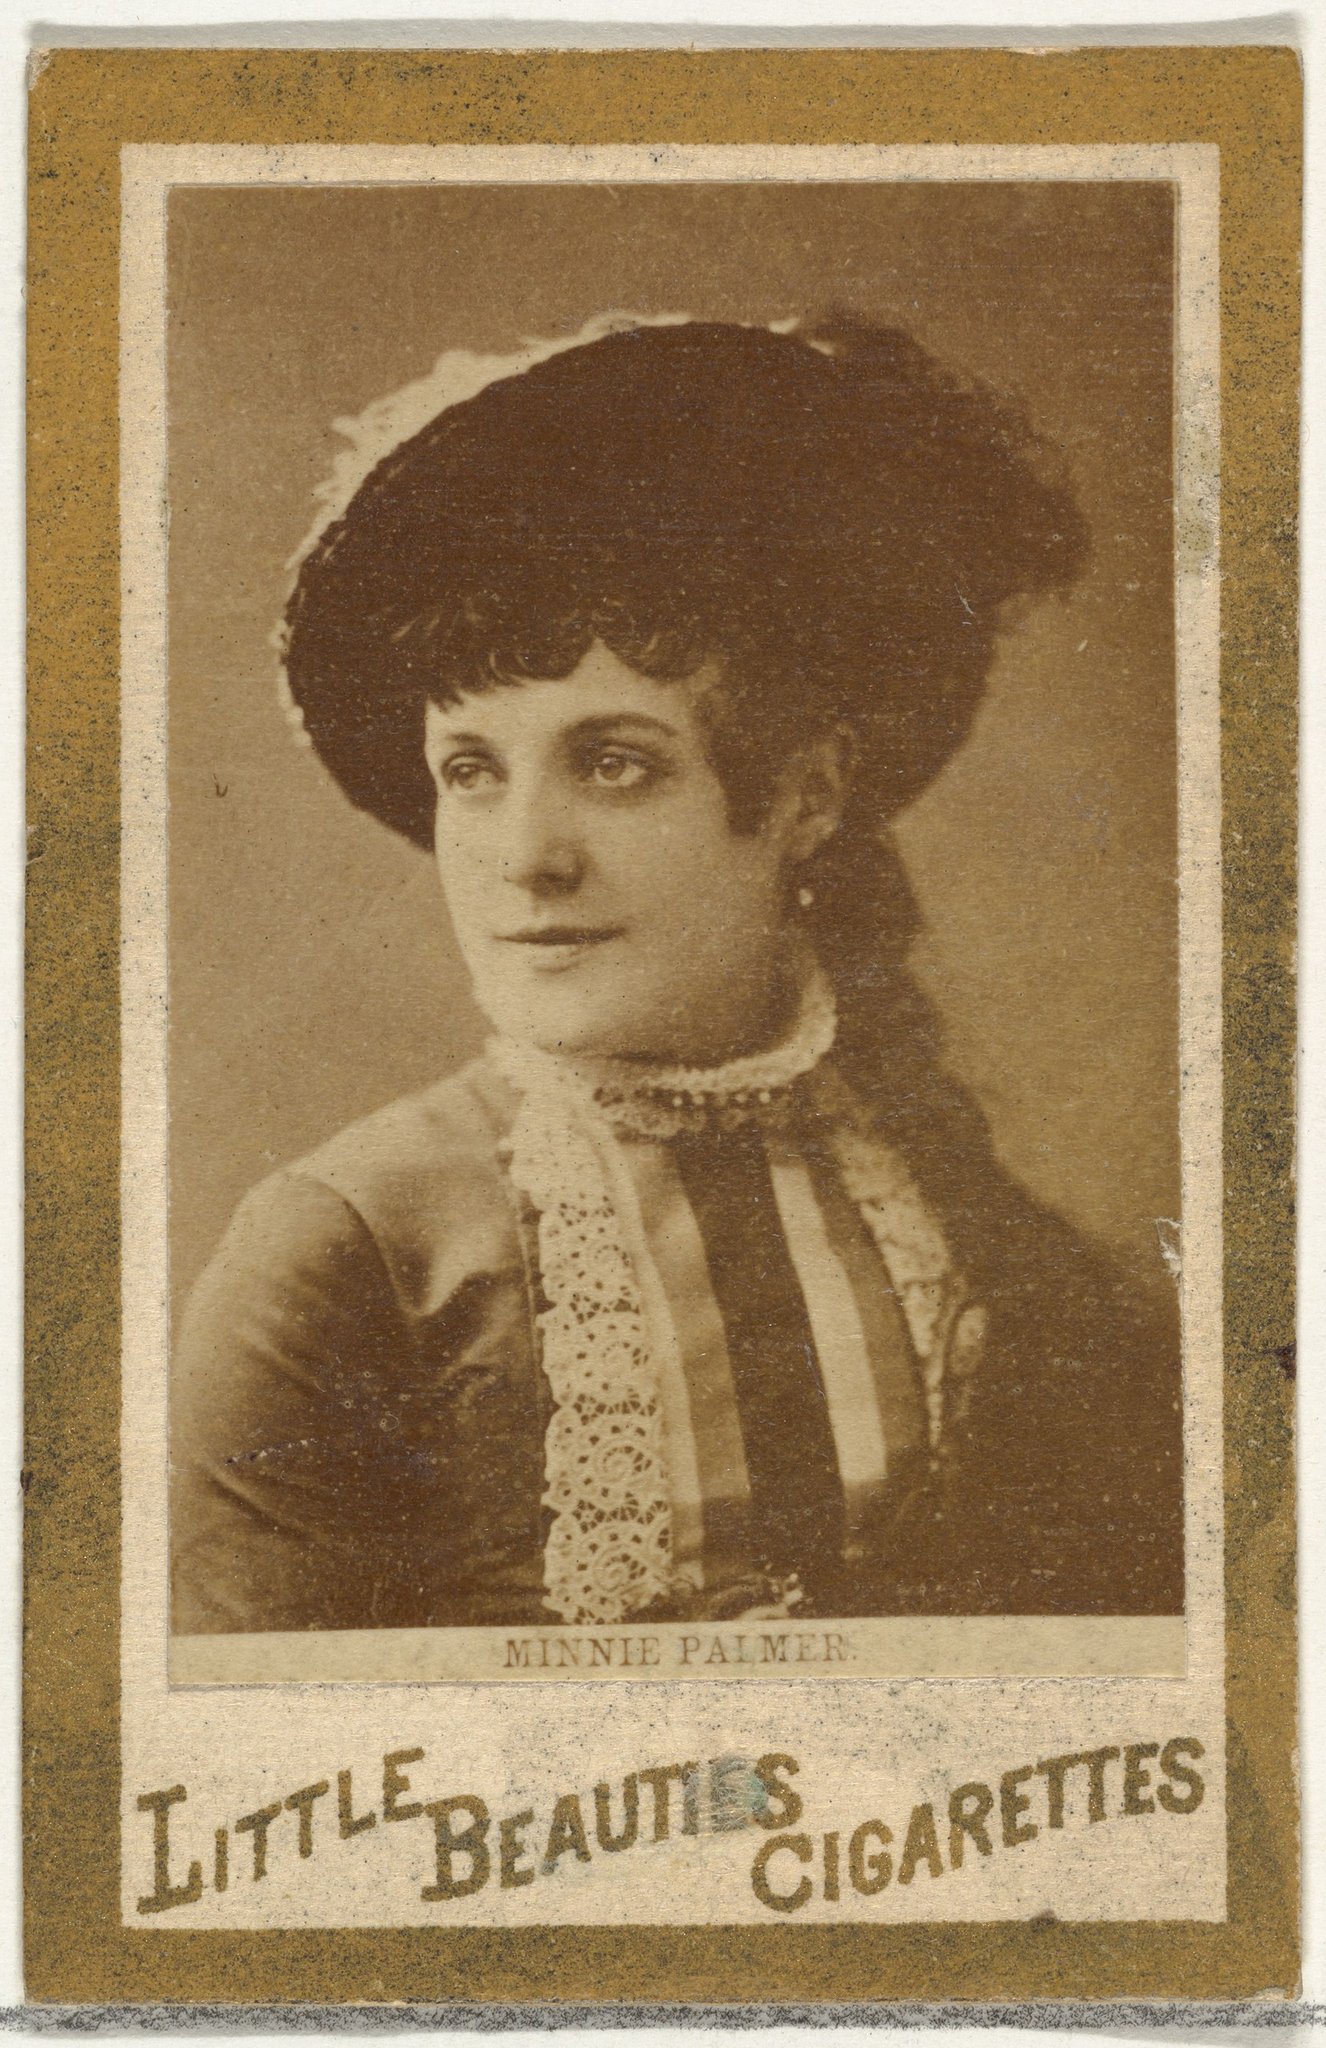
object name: photograph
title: Minnie Palmer (portrait of bust), from the Actresses and Celebrities series (N60, Type 1) promoting Little Beauties Cigarettes for Allen & Ginter brand tobacco products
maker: allen & ginter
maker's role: publisher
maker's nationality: american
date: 1887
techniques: albumen silver print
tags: portraits,women,actresses